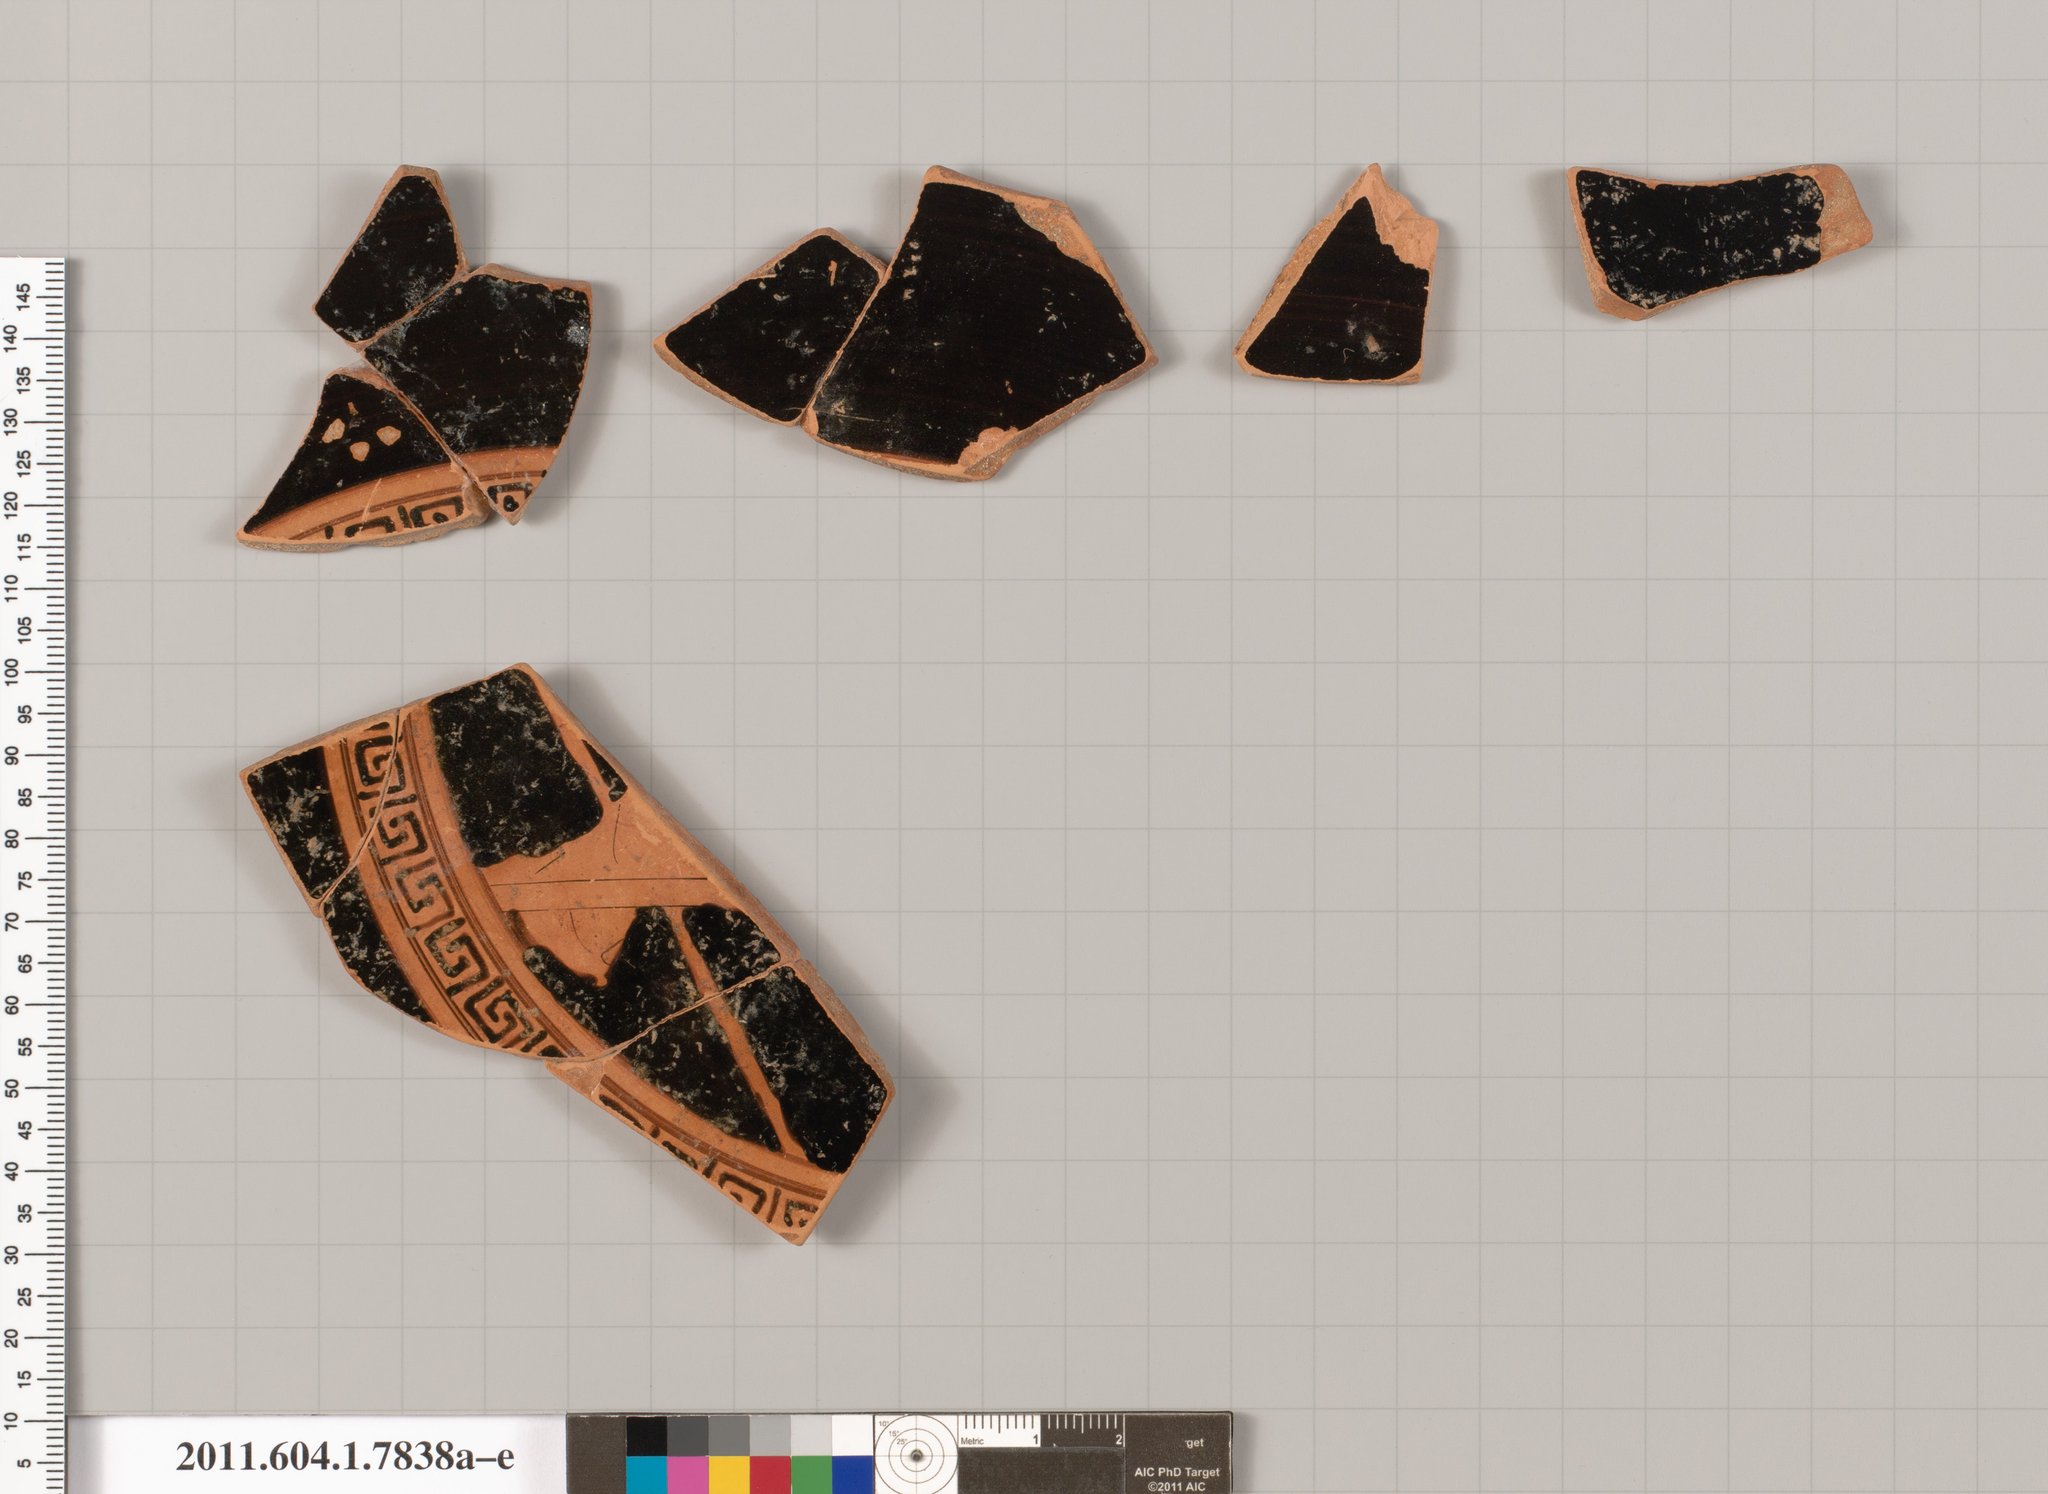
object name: kylix fragment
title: Terracotta fragments of a kylix (drinking cup)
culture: greek, attic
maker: tarquinia painter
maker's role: artist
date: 470-460 BCE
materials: terracotta